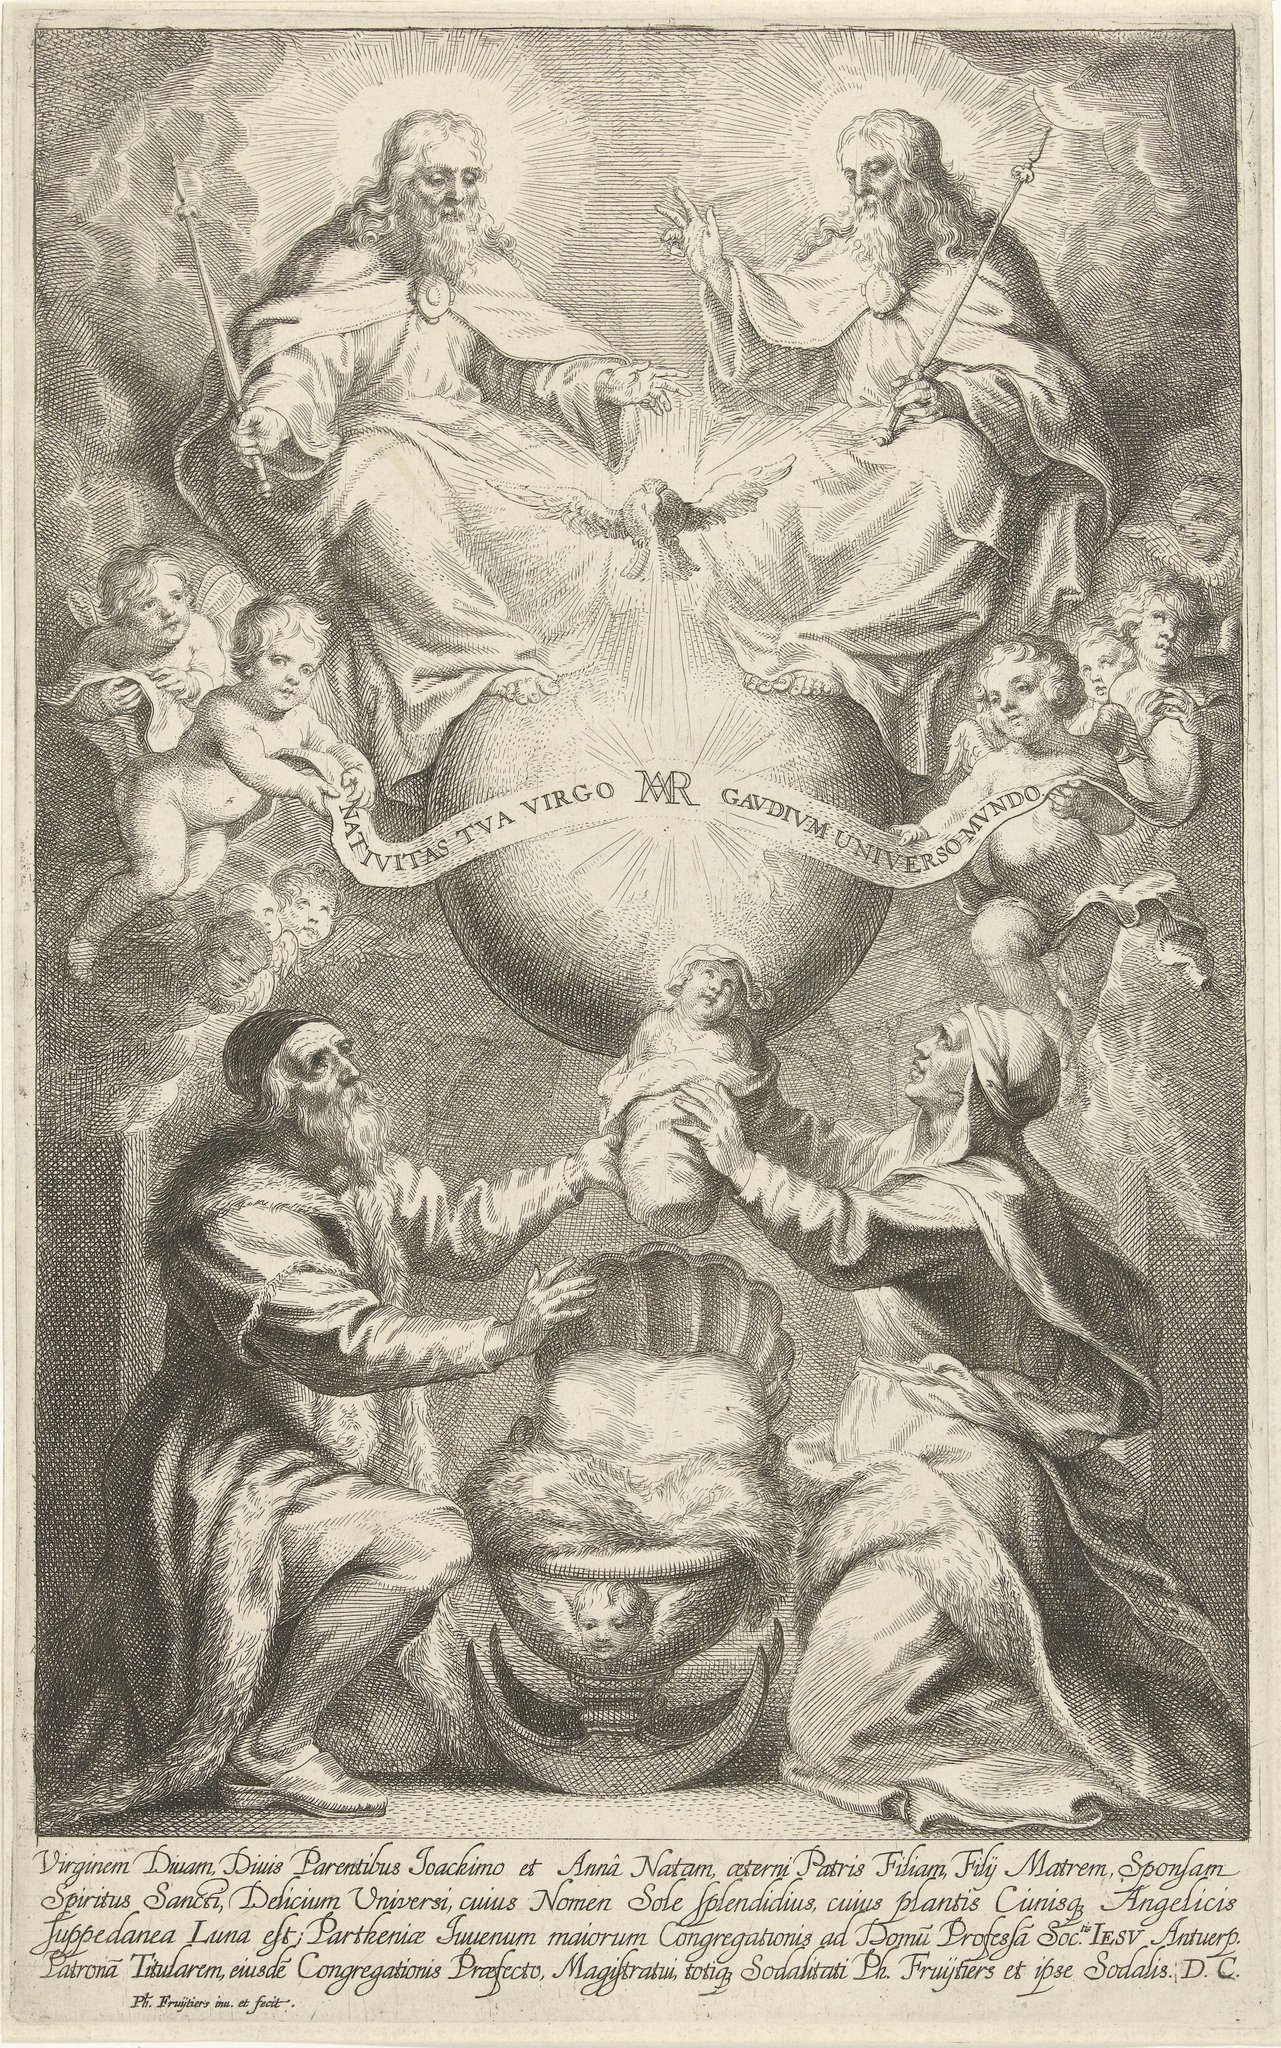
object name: print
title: Opdracht van de heilige Maagd Maria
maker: philip fruytiers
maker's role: print maker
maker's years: 1610-1666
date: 1620-1666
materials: paper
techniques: etching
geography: antwerp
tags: devout mary together with her parents; angels, and perhaps god the father present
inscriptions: collector's mark: Lugt 2228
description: Aan weerszijden van een kribbe zitten de ouders van Maria, Joachim en Anna, geknield. Samen houden ze het kind Maria in de lucht om haar op te dragen aan de tempel en haar te vervullen met de Heilige Geest die boven haar in de vorm van een duif vliegt. Vervuld met de Heilige Geest zou Maria, vanaf haar Onbevlekte Ontvangenis, geheel aan de Heer zijn toegewijd. De duif wordt links en rechts geflankeerd door God de Vader die een zegenend gebaar maakt. Boven Joachim en Anna vliegen engelen die voor een bol een banderol vasthouden met de tekst: Nativitas Tua Virgo MAR Gaudium Universo Mundo. In de marge een vierregelige tekst in Latijn.